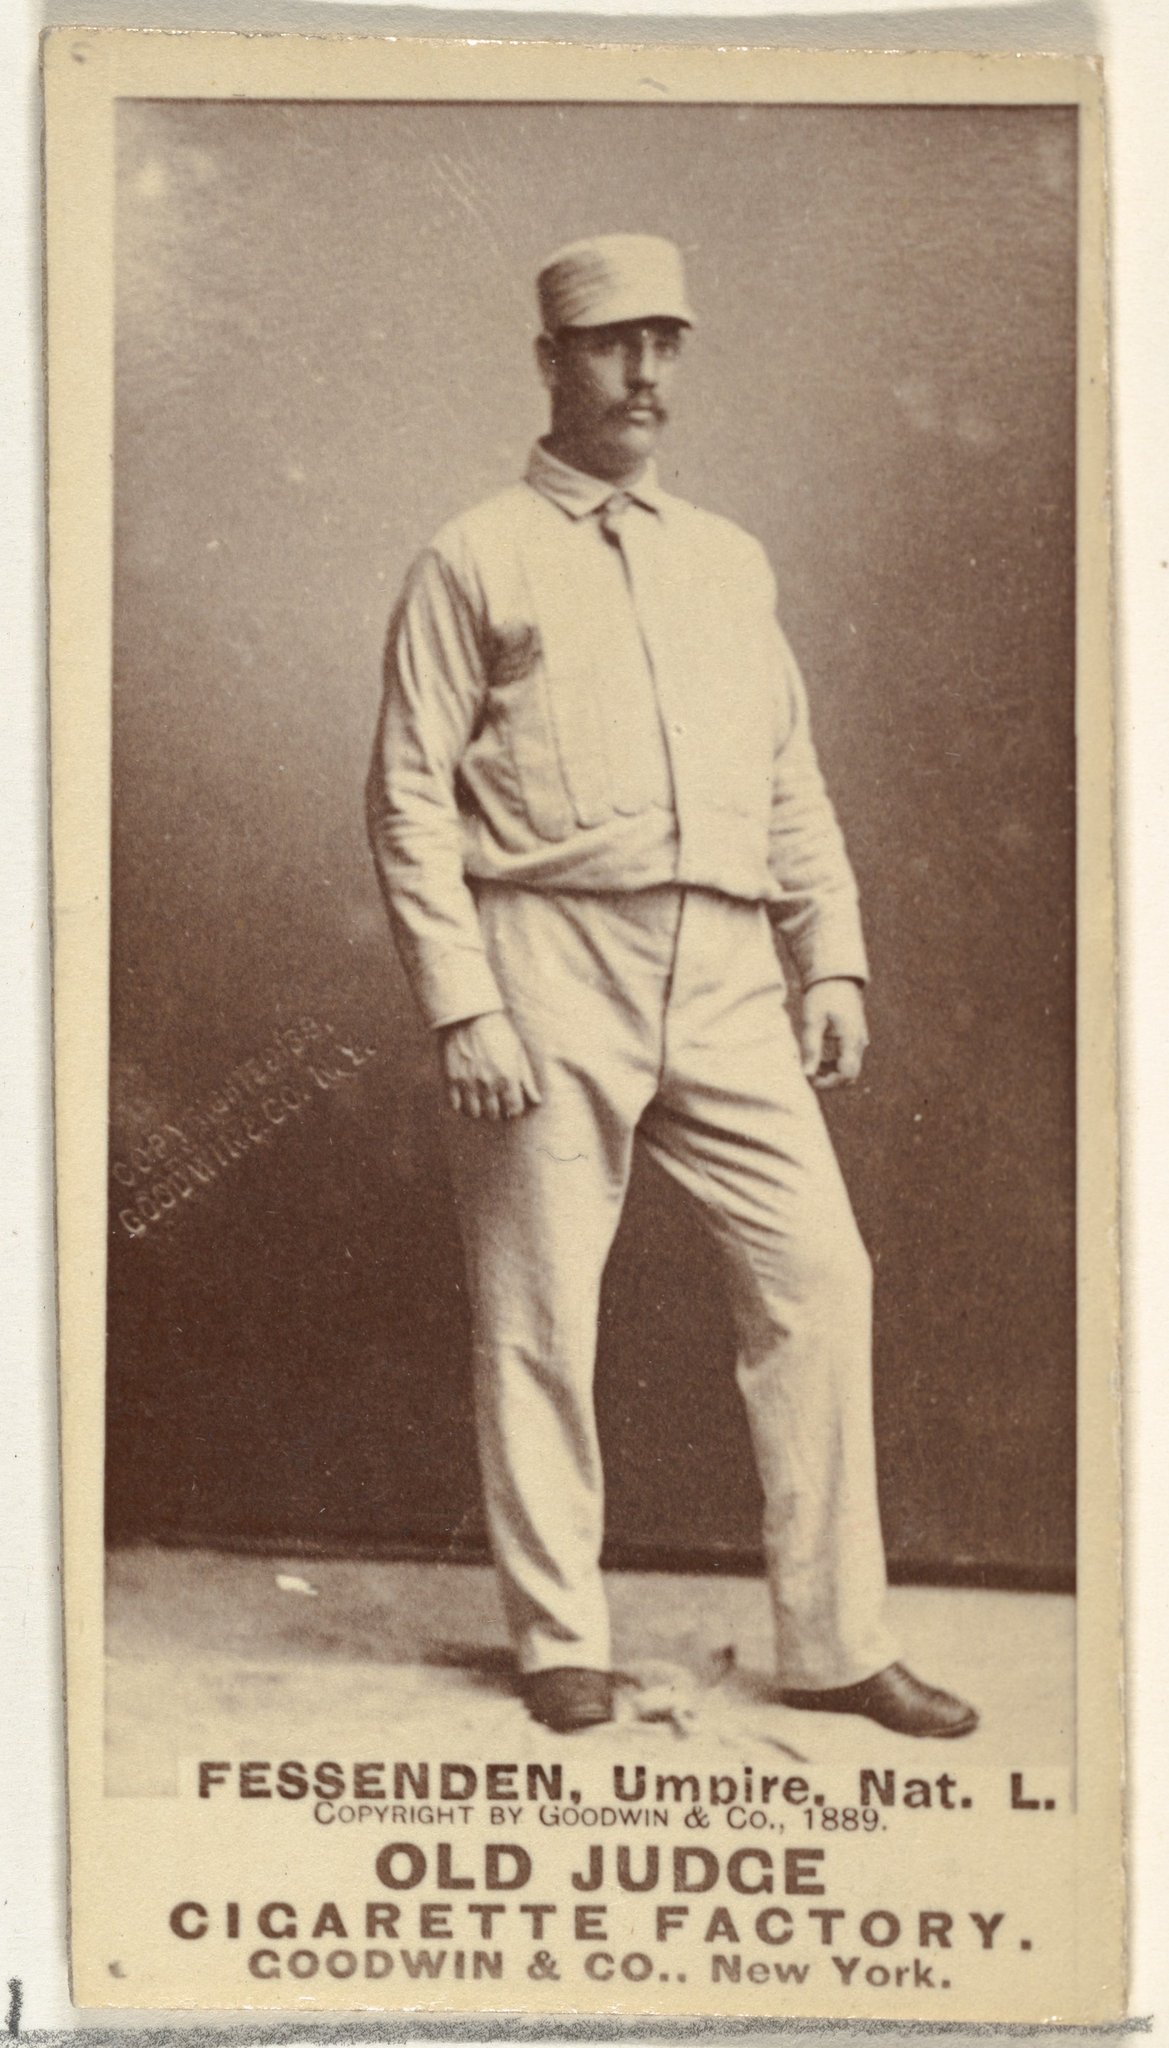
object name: baseball card, photograph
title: Wallace Fessenden, Umpire, National League, from the Old Judge series (N172) for Old Judge Cigarettes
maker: goodwin & company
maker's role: publisher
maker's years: 1850-1950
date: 1889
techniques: albumen silver print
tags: men,portraits,baseball,athletes